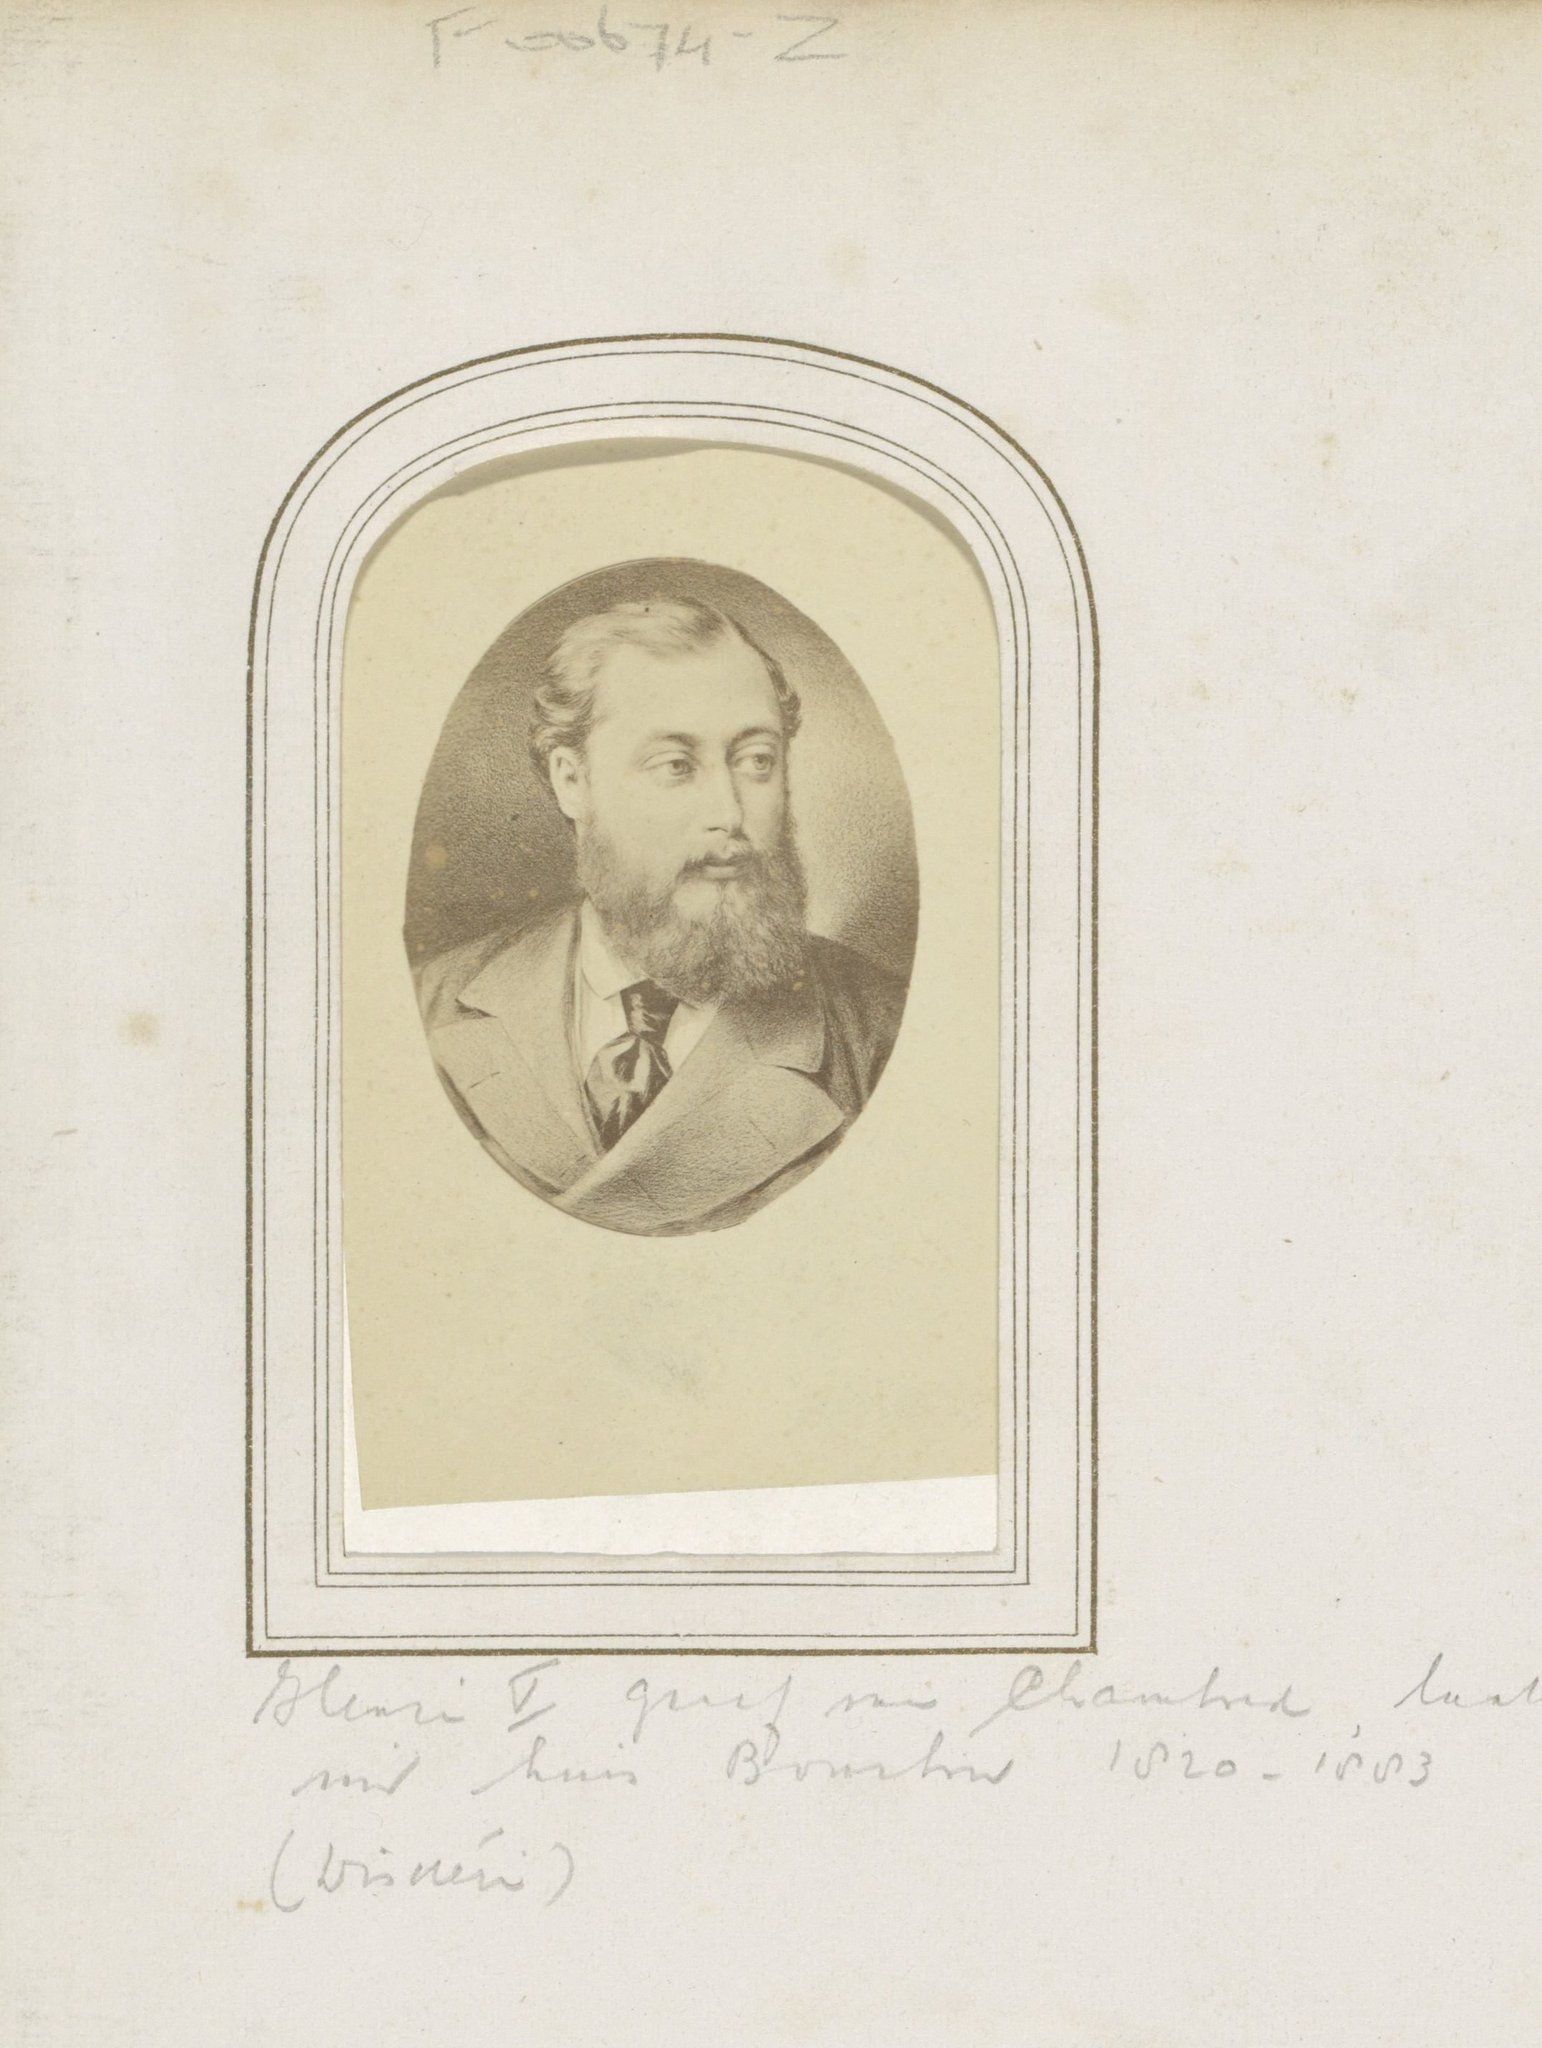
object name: photograph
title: Fotoreproductie van (vermoedelijk) een getekend portret van Hendrik van Artois Bourbon, graaf van Chambord en Frans troonpretendent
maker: andré-adolphe-eugène disdéri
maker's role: fotograaf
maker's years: 1819-1889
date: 1870-1880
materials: cardboard, paper, photographic support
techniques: albumen print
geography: paris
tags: adult man, historical persons, neck-gear ~ clothing, clothing for the upper part of the body, beard, paris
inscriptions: address: ‘Paris, 8 Boulevard des Italiens’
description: Onderdeel van Fotoalbum met 123 cartes-de-visite van leden van Europese vorstenhuizen, politici en bekende personen.